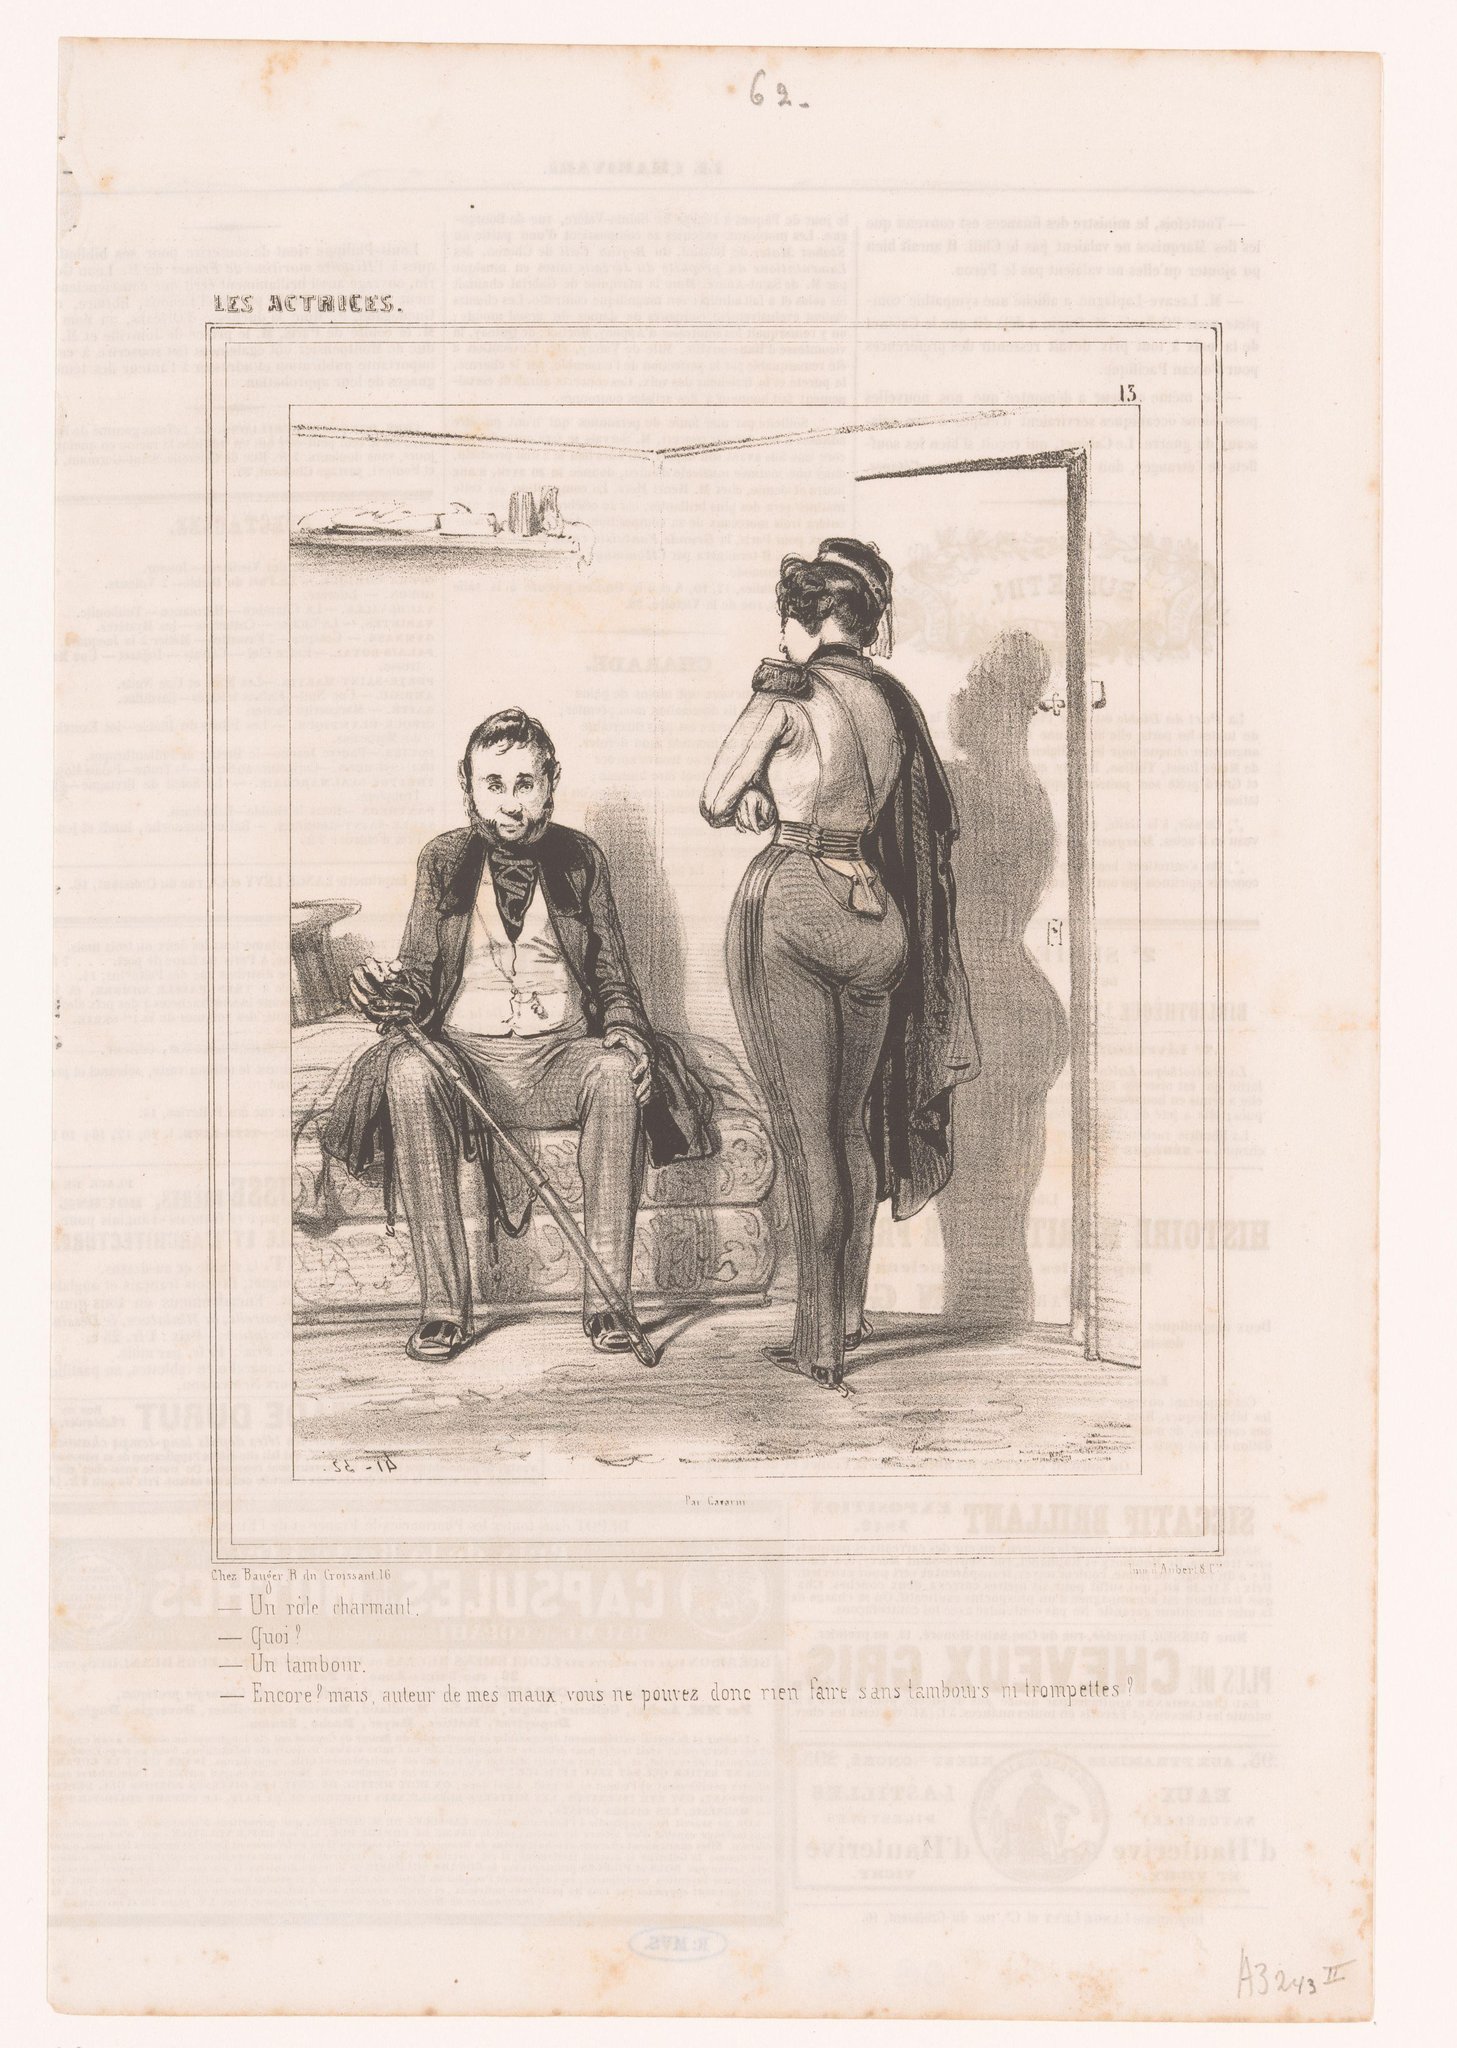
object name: cartoon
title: Actrice in discussie met toneelschrijver over haar rol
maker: paul gavarni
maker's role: draughtsman, print maker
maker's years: 1804-1866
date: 1843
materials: paper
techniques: lithograph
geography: paris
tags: writer, poet, author, actor, actress (non-work situations)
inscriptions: collector's mark: Lugt 2228a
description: Prent gebruikt voor: La Caricature, 27 juni 1841, en voor: Le Charivari, 26 april 1843.